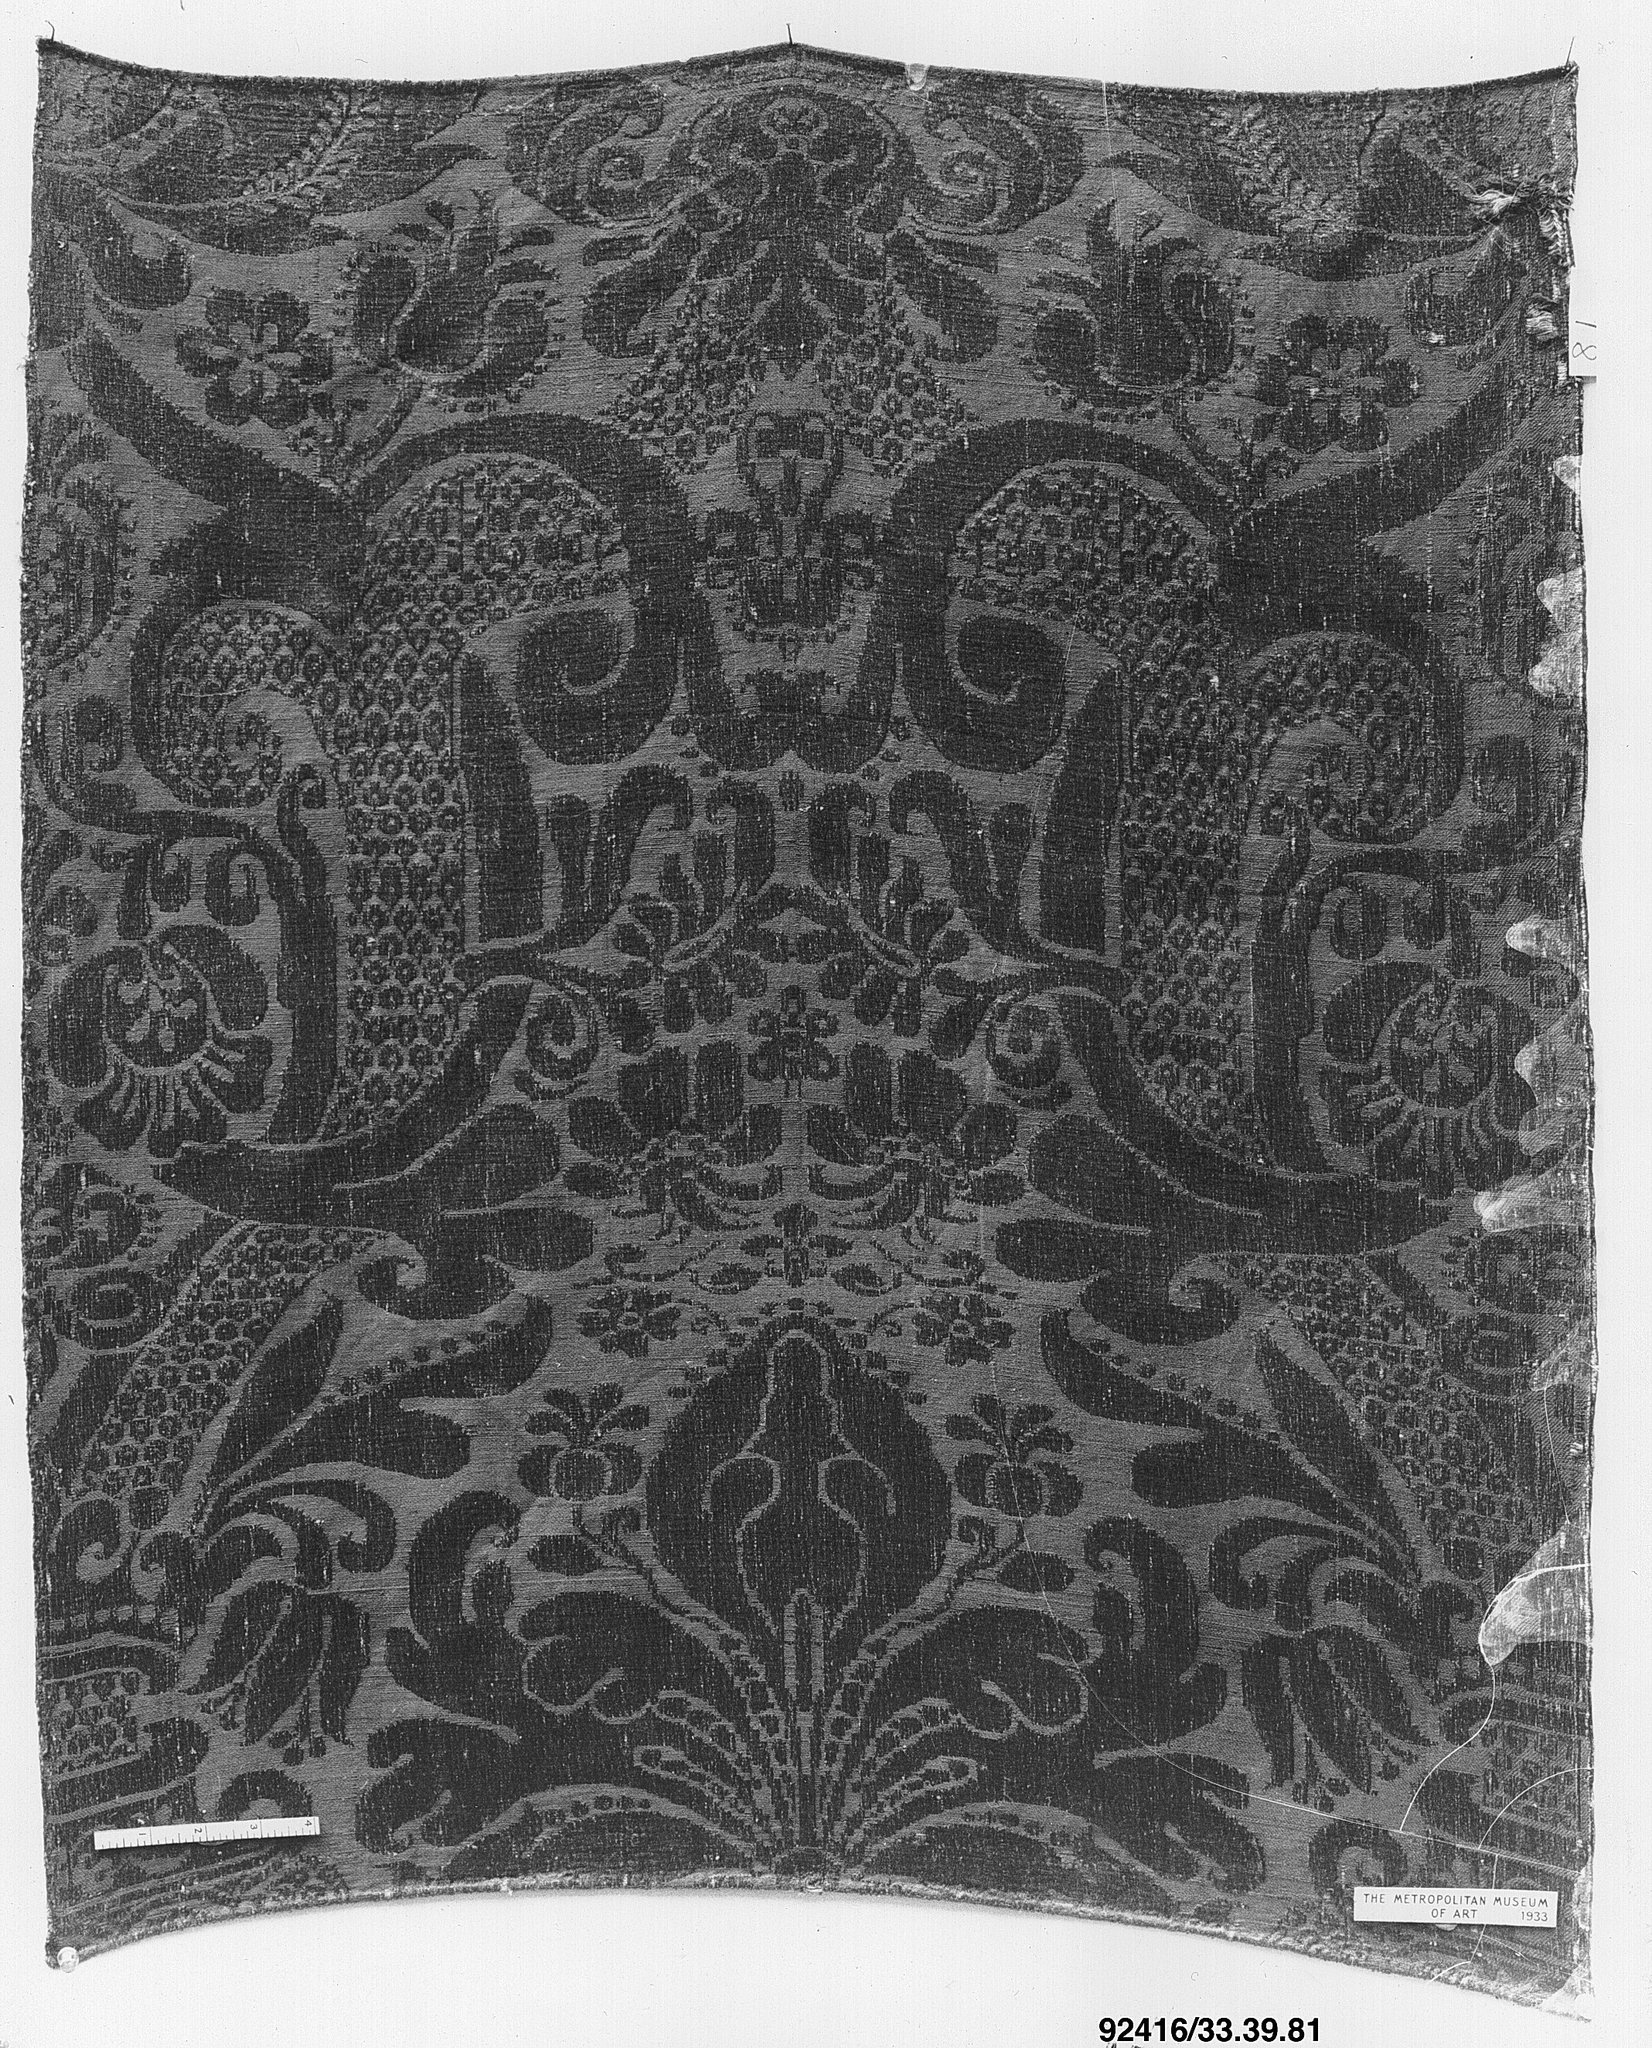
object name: piece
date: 1601-1800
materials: linen, silk